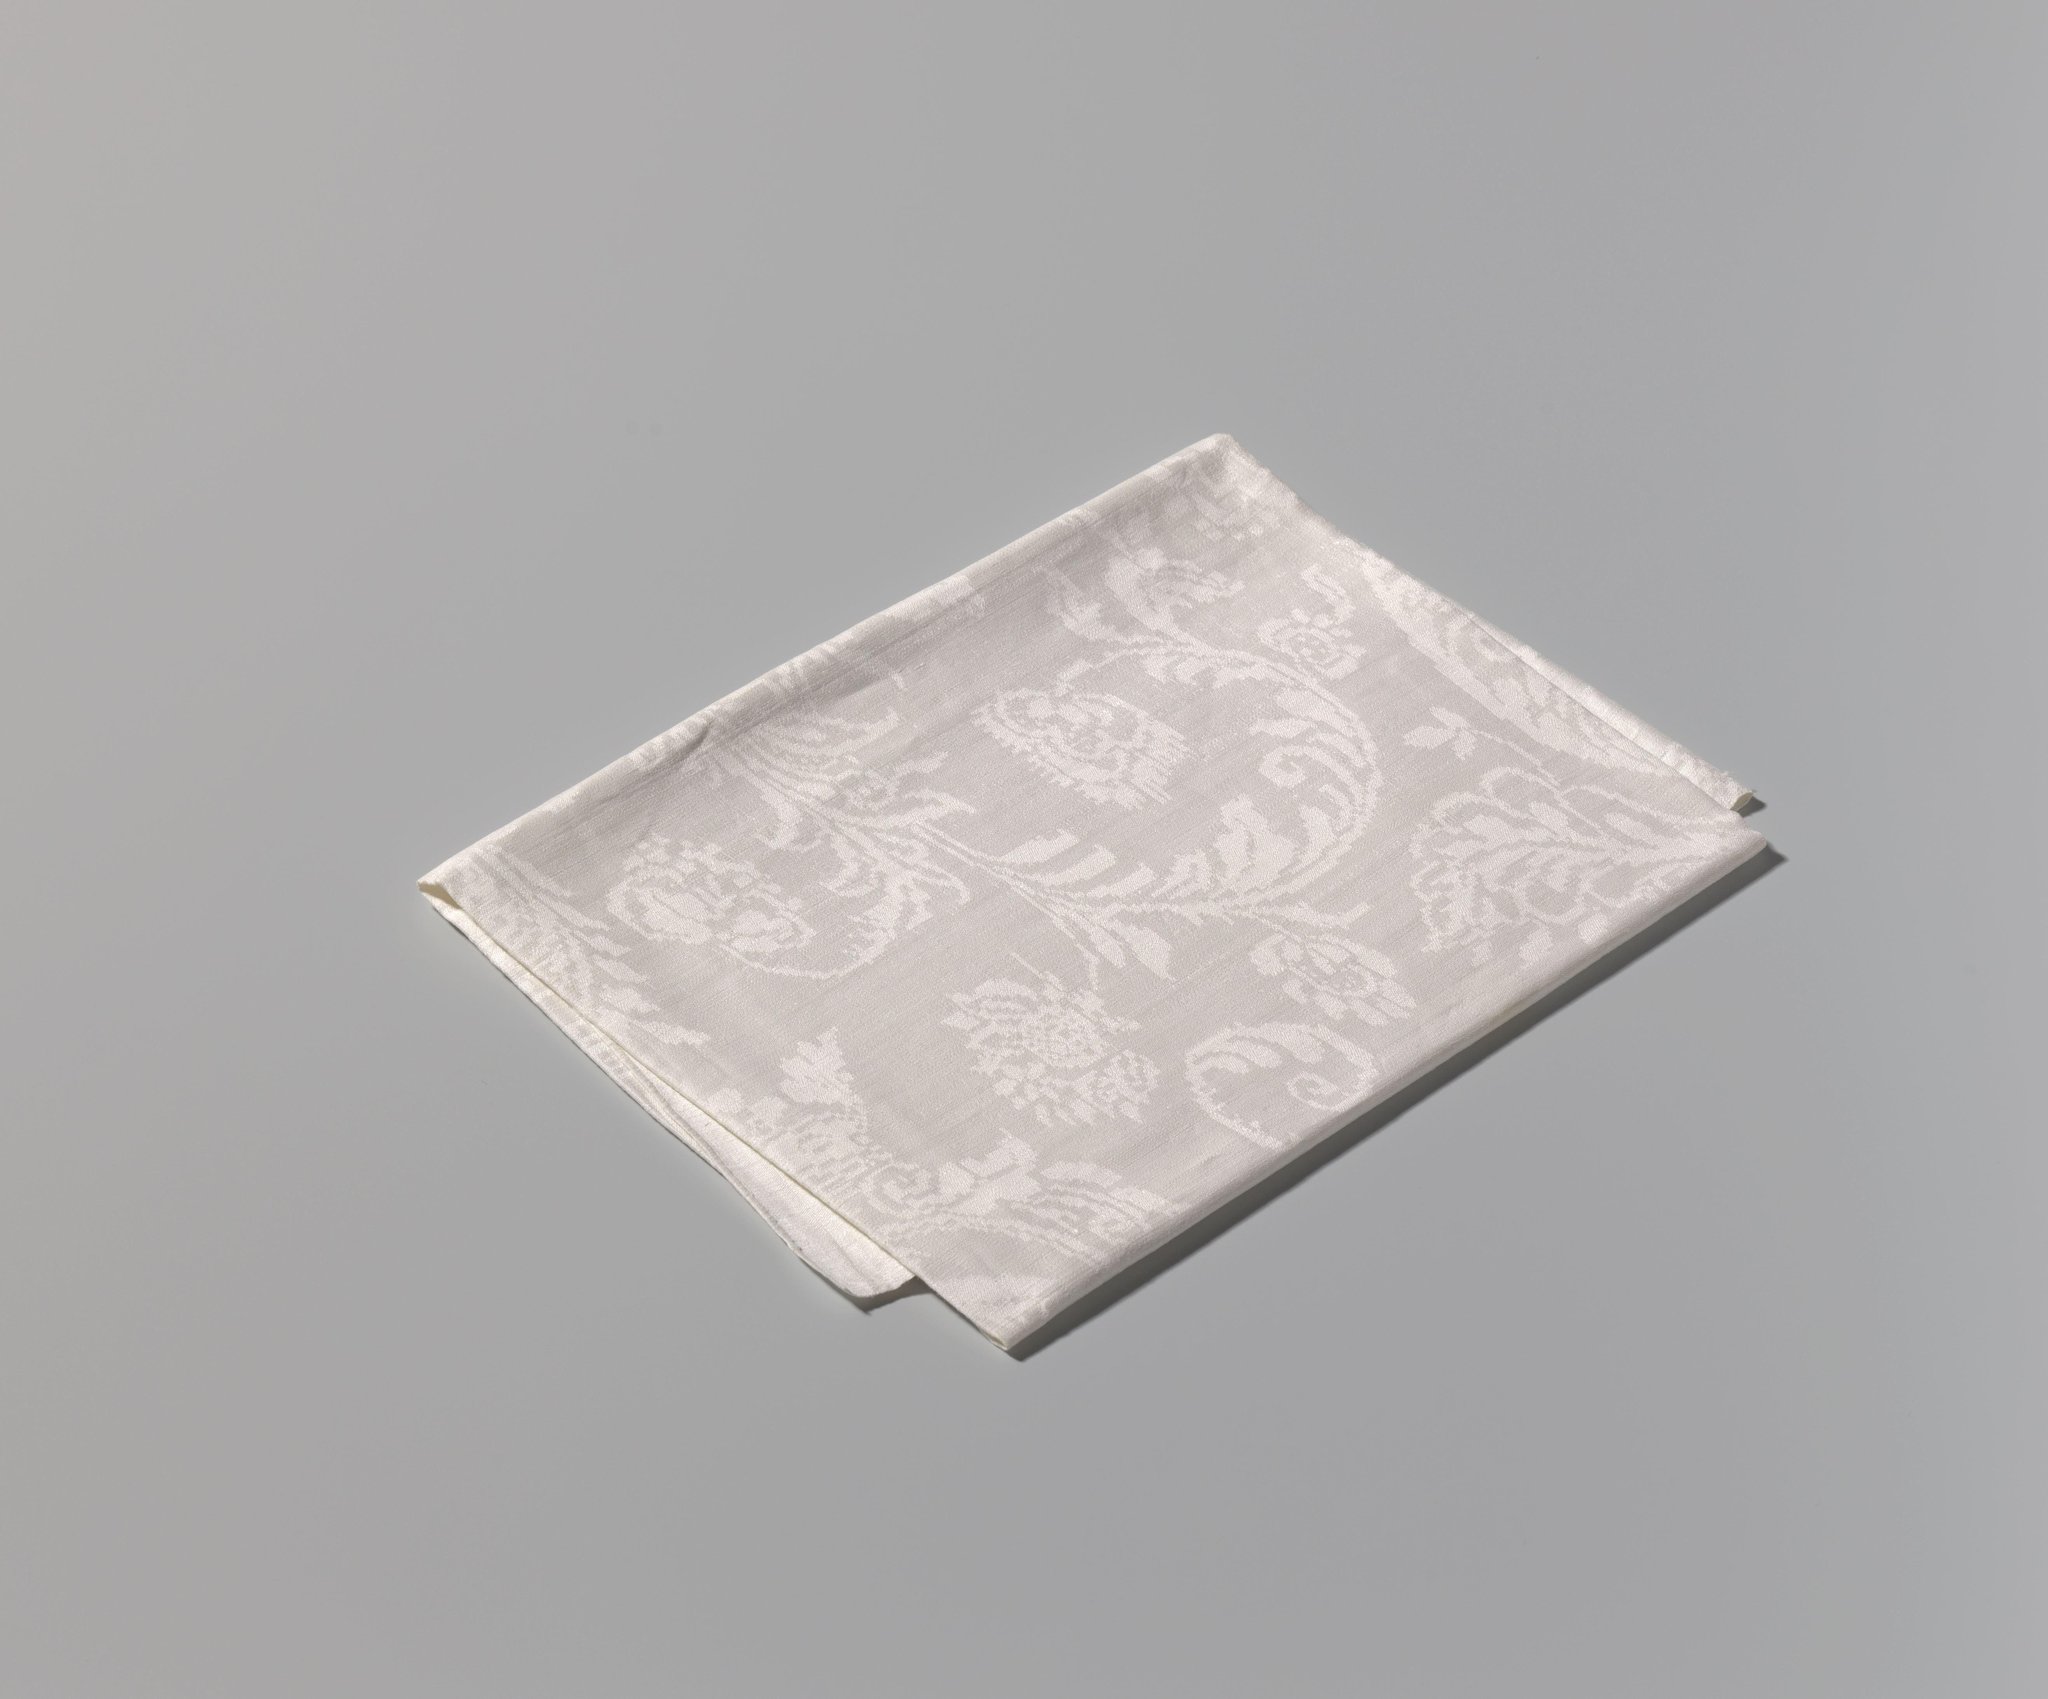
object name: napkin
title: Servet met het wapen van Cornelis Hop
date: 1700-1724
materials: linen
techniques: damask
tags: cornelis hop (ii)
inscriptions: mark: ‘H’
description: Servet van linnendamast met het wapen van Cornelis Hop. Middenveld: symmetrische patroon van veelsoortige voluutranken met op de knooppunten geblokte verdikkingen. Daartussen een liggend ovaal schild met een wapen van Cornelis Hop (1685-1762), ambassadeur aan het hof van koning Lodewijk XV van Frankrijk: gevierendeeld, 1 en 4 kopvogel staande op bol (de vogel van 1 omgewend, die van 4 omziend); 2 en drie twee afgewende vleugels. Hartschild gedeeld: 1 een dwarsbalk, 2 rechts een vijfpuntige ster, links een gewende wassenaar. Het schild gedekt met vijfbladerige kroon. Schildhouders: rechts een afgewende adelaar, links een afgewende leeuw. Randen: wapentrofeeën. Hoeken: een rondas. Rondom blokkenrand.